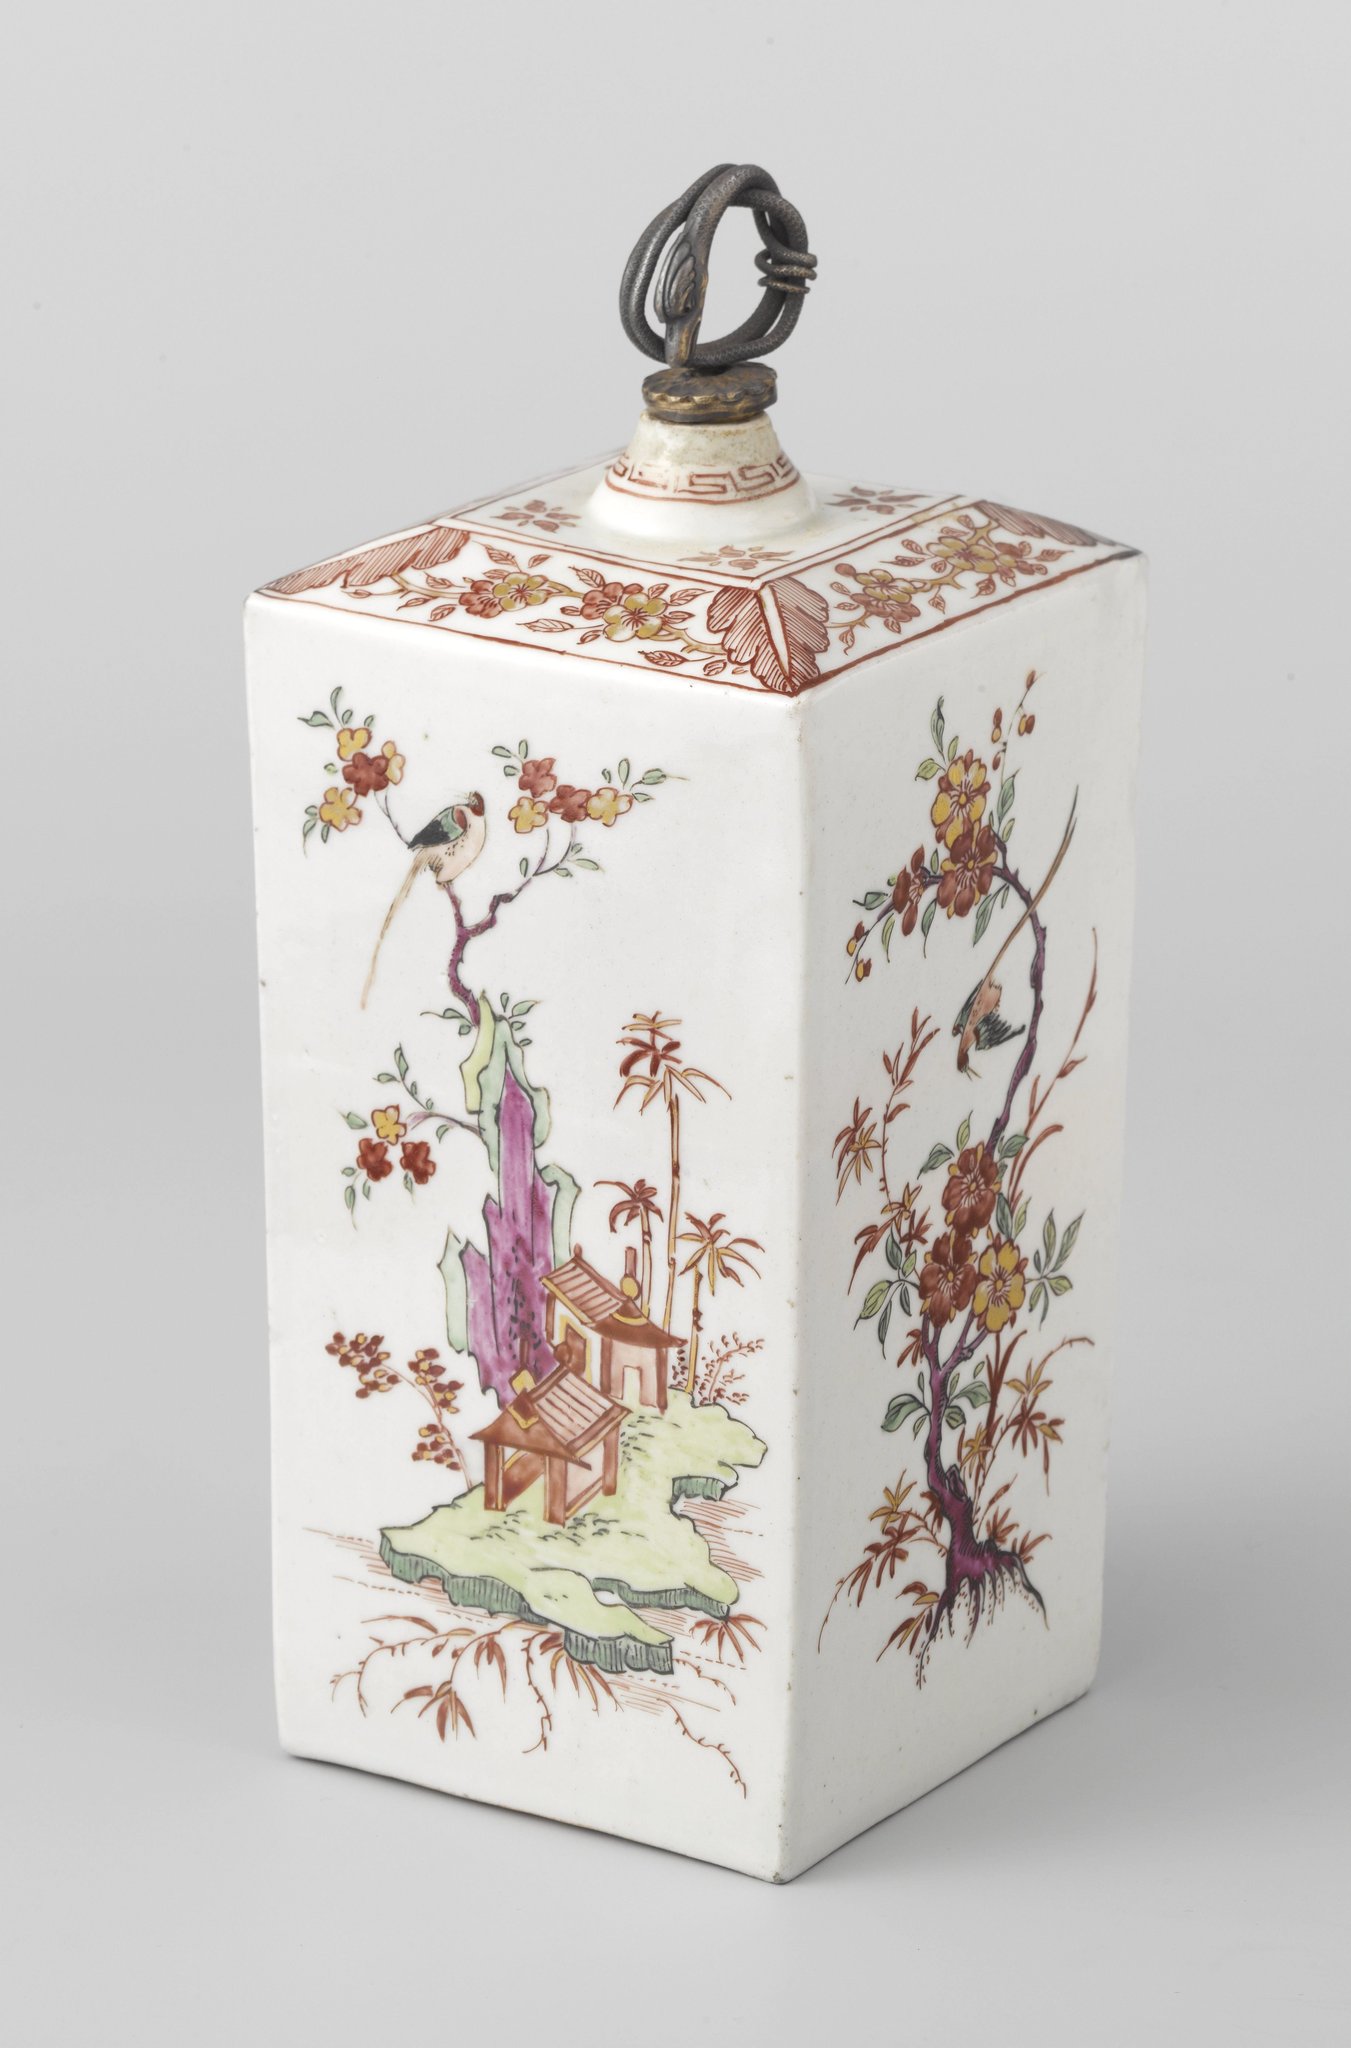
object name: bottle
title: Square bottle with birds, flowering plants and pavilions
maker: Anonymous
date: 1700-1724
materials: bronze, glaze, gold, paint, porcelain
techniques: firing, forming, gilding, vitrification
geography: japan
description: Vierkante fles van porselein met een verguld, bronzen dop, beschilderd op het glazuur in rood, groen, geel, paars, zwart en goud. Op de wanden tweemaal paviljoens op een eiland met rotsen en bloeiende planten (bamboe), een vogel op een tak, en tweemaal een vliegende vogel bij een prunustak en bamboe. Op de schouder een band met prunustakken en een bladmotief; rond de hals ranken. Op de hals een meanderpatroon. De dop is in de vorm van een gevlochten ring, eindigend in een hoo-vogelkop op een bloemrozet. De rand is afgeslepen. Arita, in Europa gedecoreerd[?] in de Japanse Kakiemon-stijl.